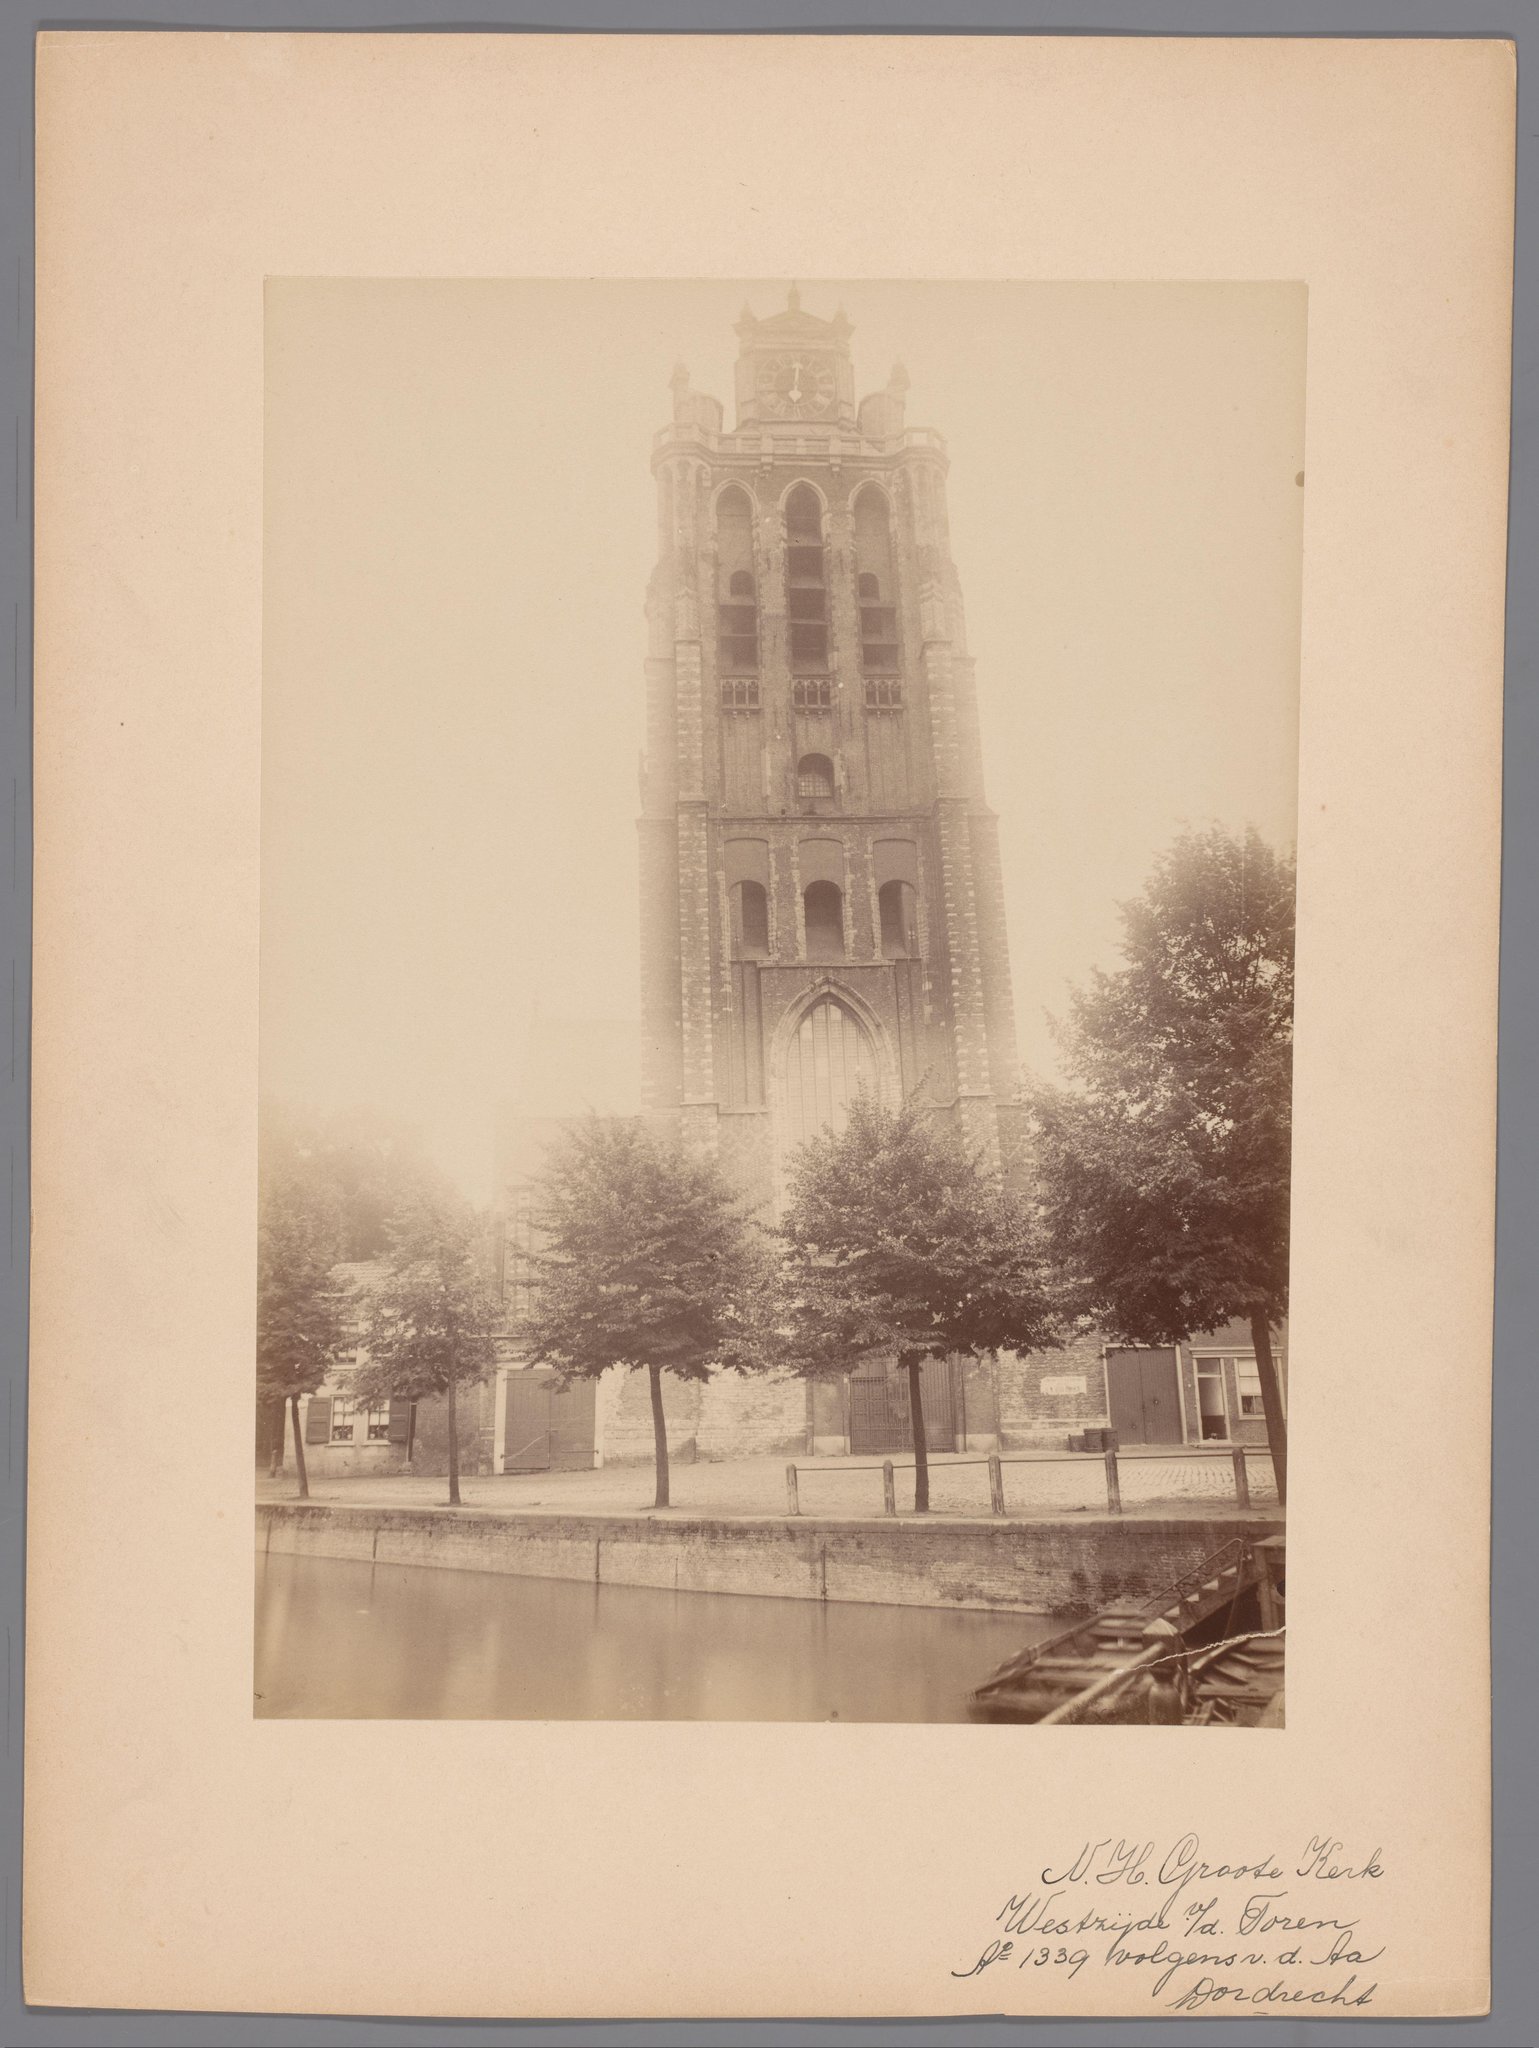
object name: photograph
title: Gezicht op de toren van de Grote of Onze-Lieve-Vrouwenkerk te Dordrecht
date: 1880-1910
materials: cardboard, photographic support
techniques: albumen print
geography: korte geldersekade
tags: church (exterior), parts of church exterior and annexes: tower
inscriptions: annotation: ‘Dordrecht/ Gezicht op de westzijde v/d toren/ Anno 1339 volgens v/d [...]’, annotation: ‘N.H. Groote Kerk/ Westzijde v/d Toren/ Anno 1339 volgend v.d. [...]/ Dordrecht’